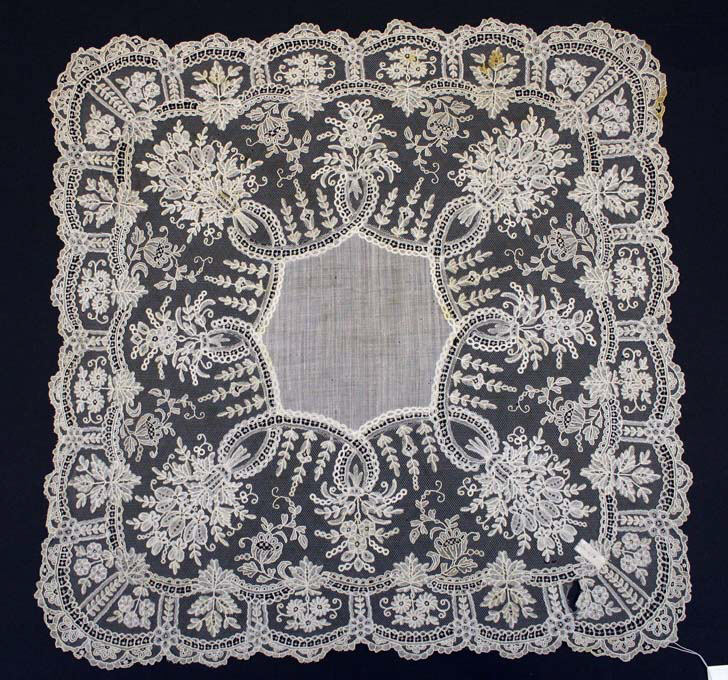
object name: handkerchief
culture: american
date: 1850-1869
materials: cotton, linen